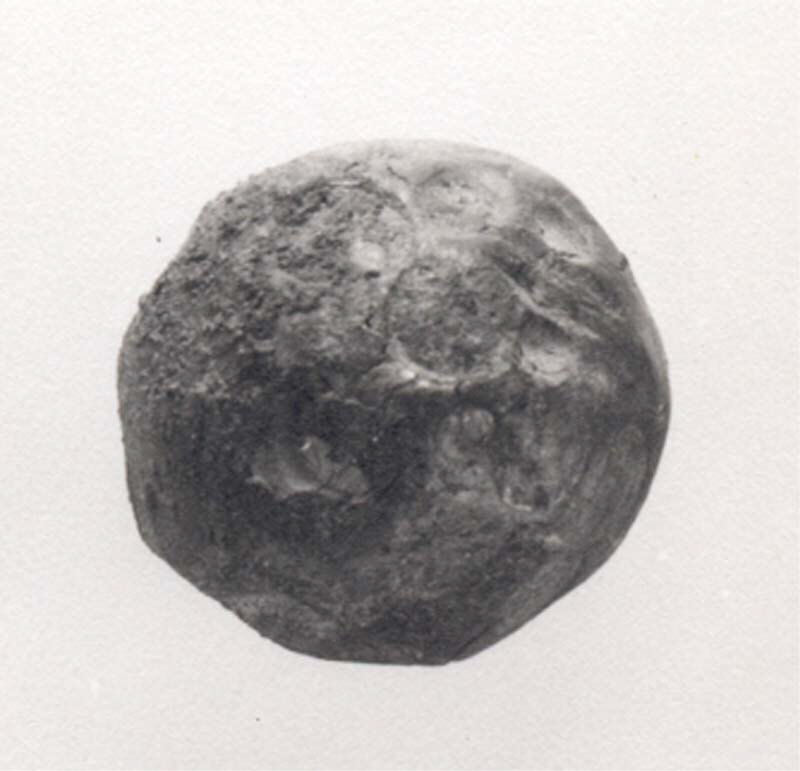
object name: sealing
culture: sasanian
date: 601-700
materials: clay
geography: iran